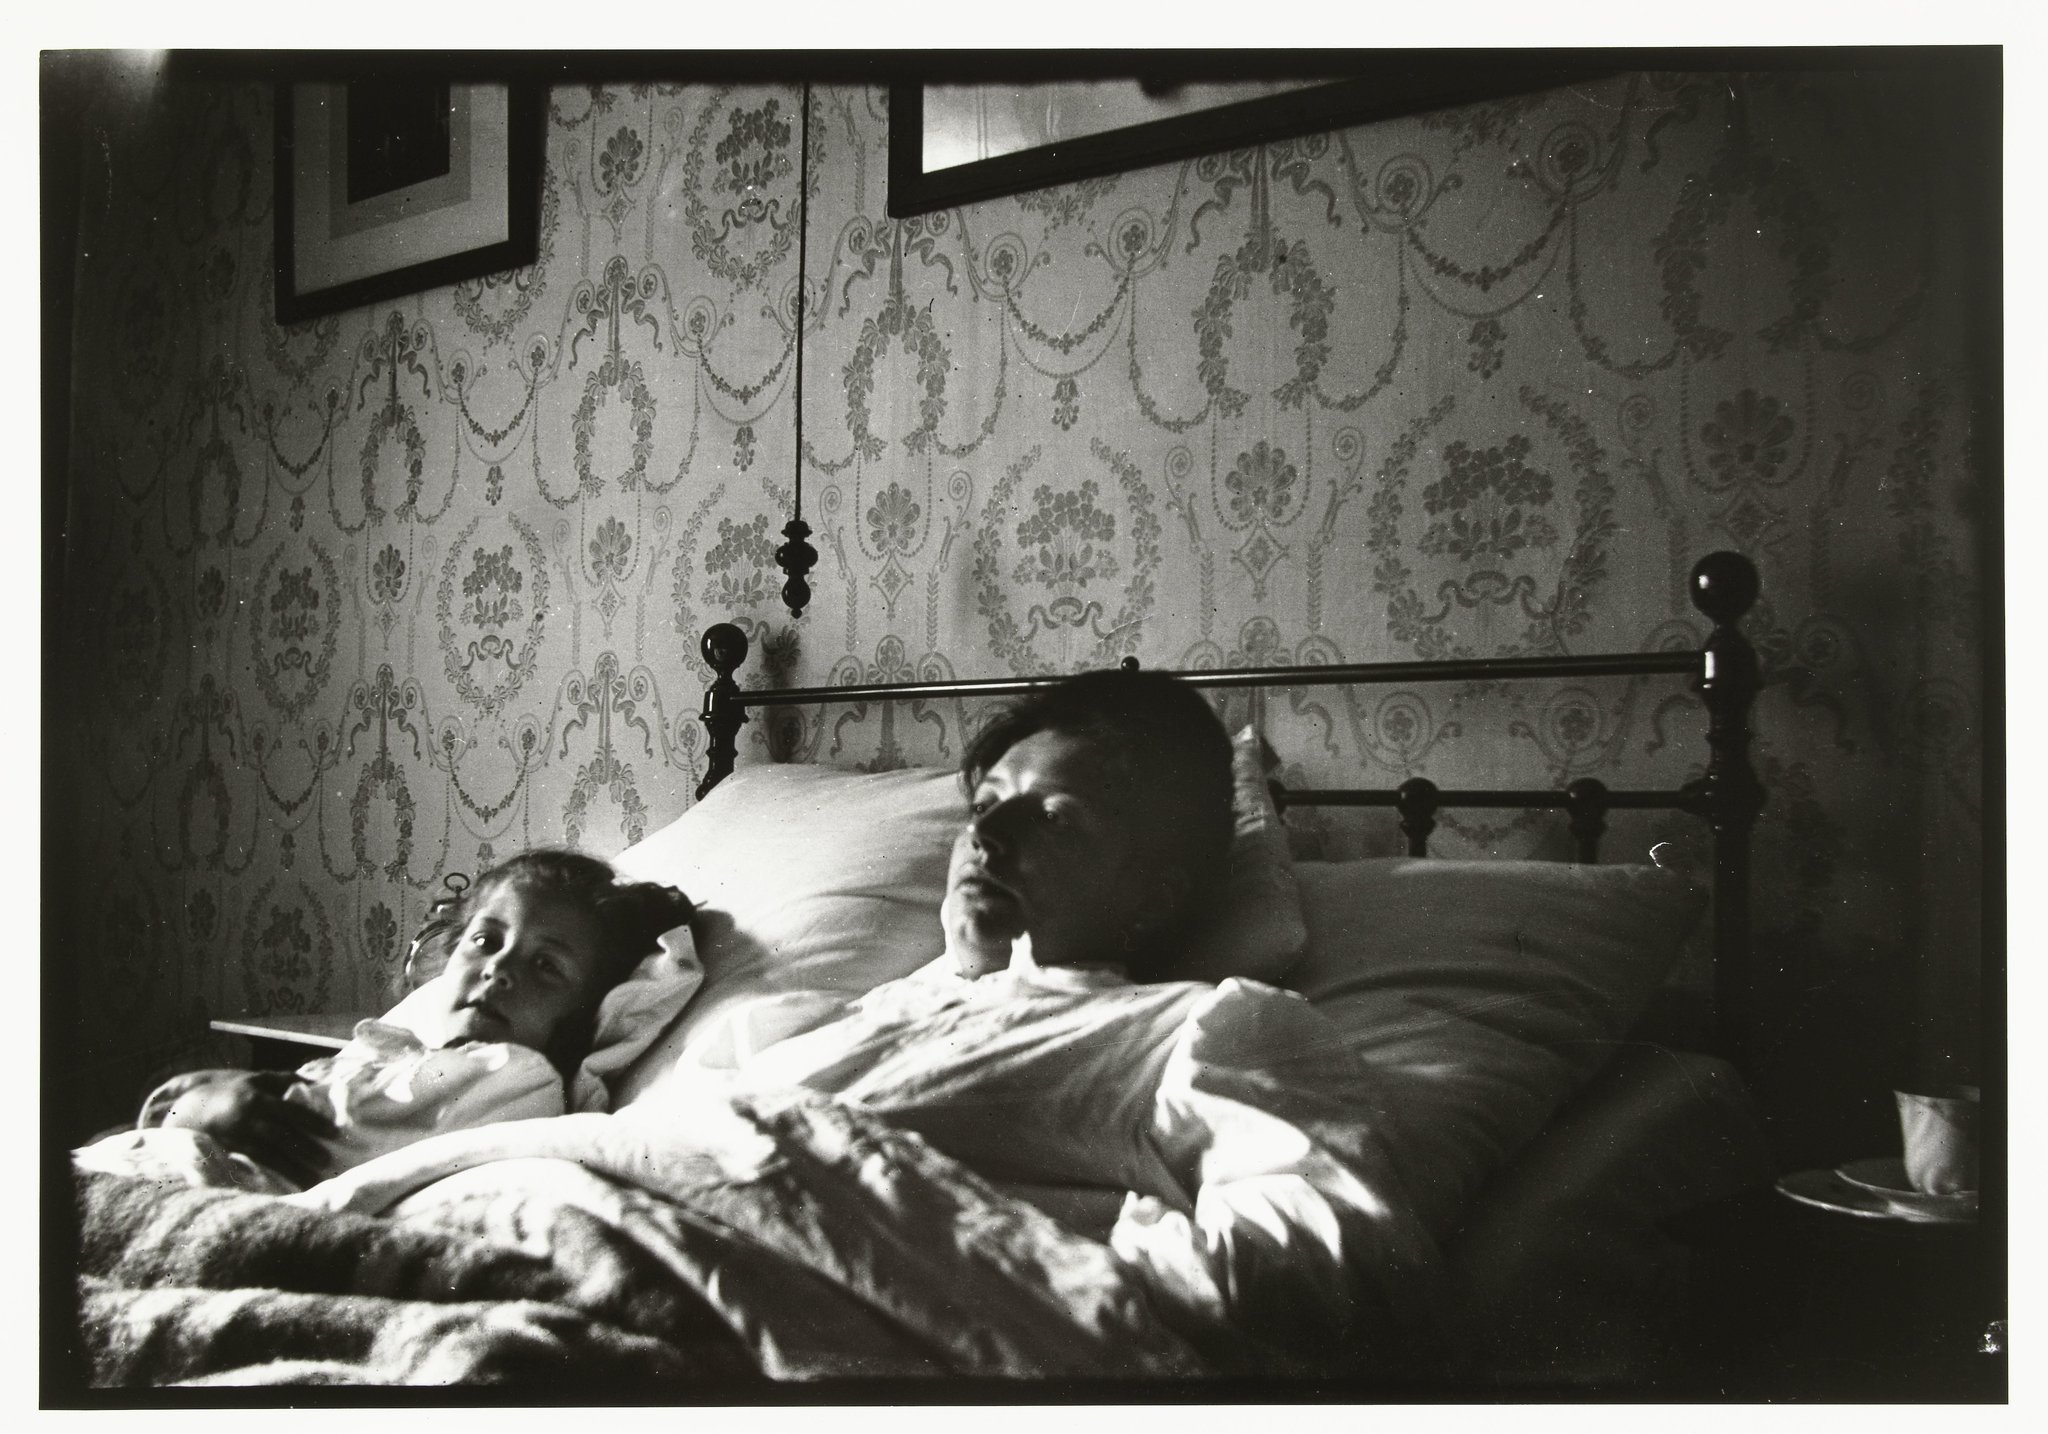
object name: photograph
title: Marie Breitner en een meisje bij het ontwaken in bed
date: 1890-1910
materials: paper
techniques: gelatin silver print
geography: amsterdam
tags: amsterdam, marie jordan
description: Moderne afdruk van negatief BR 1722 (collectie RKD).